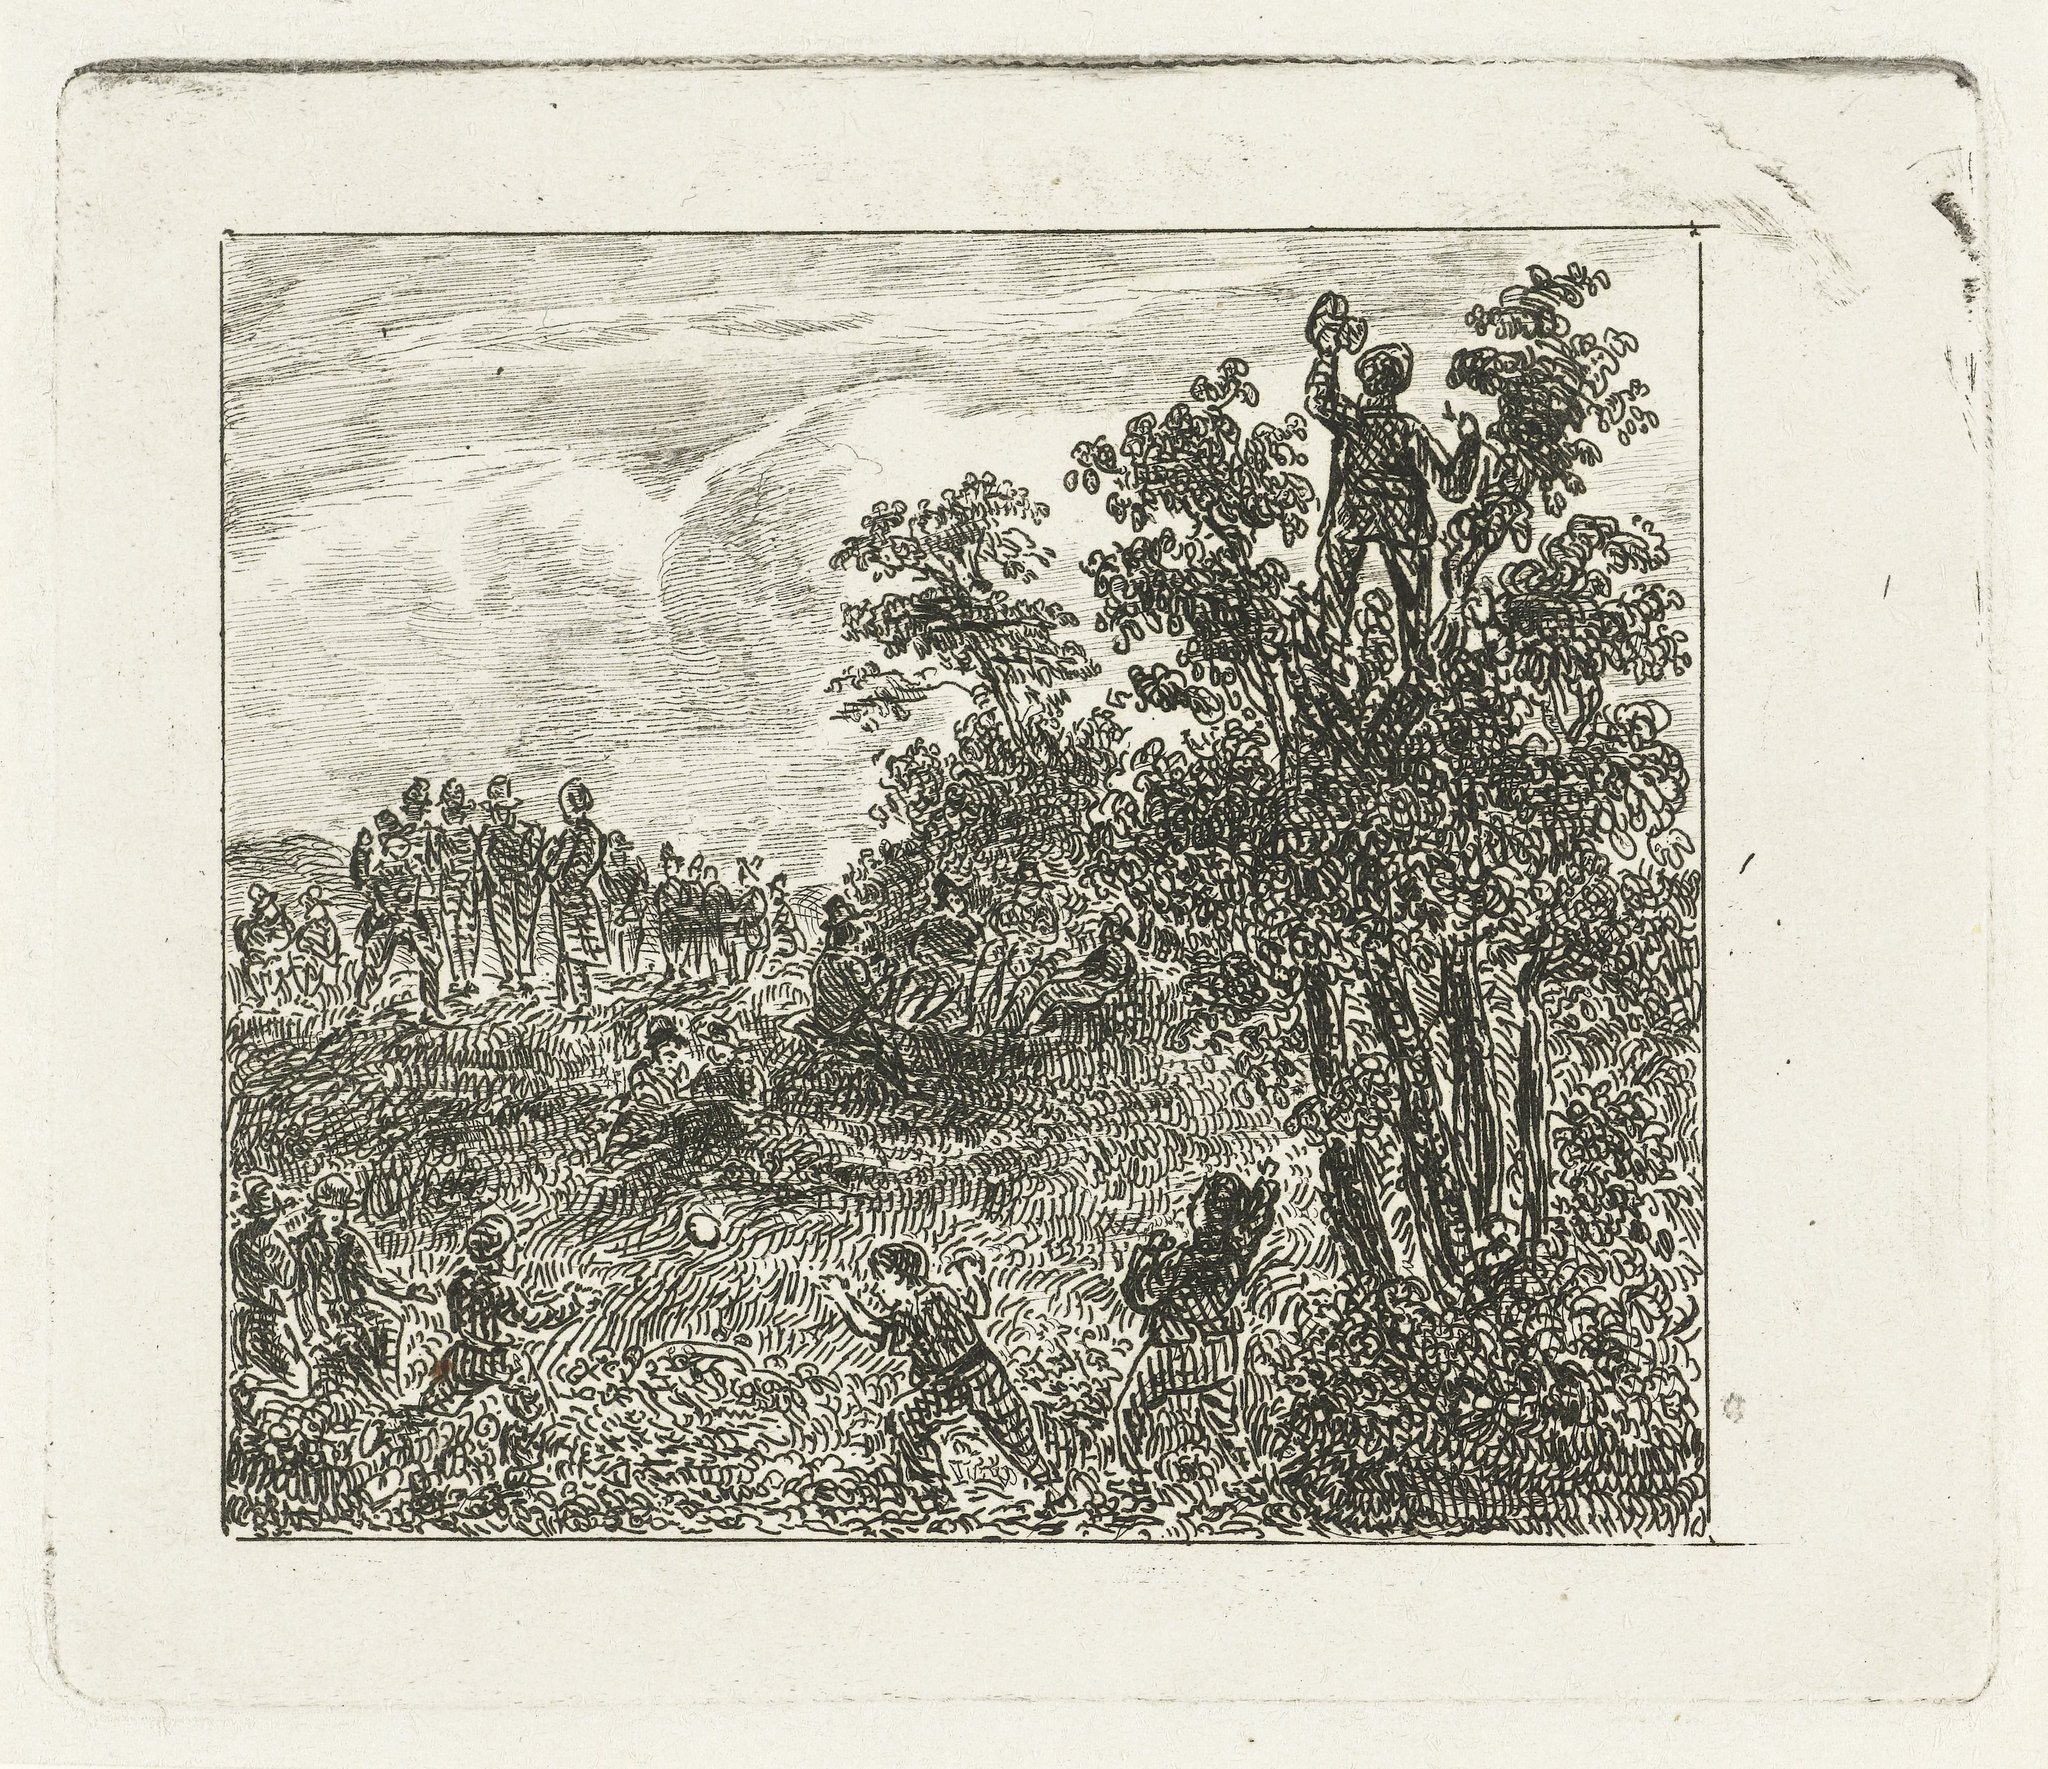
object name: print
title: Rustend groepje wandelaars met balspelende kinderen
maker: johannes adrianus van der drift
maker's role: print maker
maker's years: 1808-1883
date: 1823-1883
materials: paper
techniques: etching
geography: netherlands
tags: outdoor gathering, 'délices à la campagne', games using special objects (marbles, top, hoop, etc.)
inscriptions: collector's mark: Lugt 2228